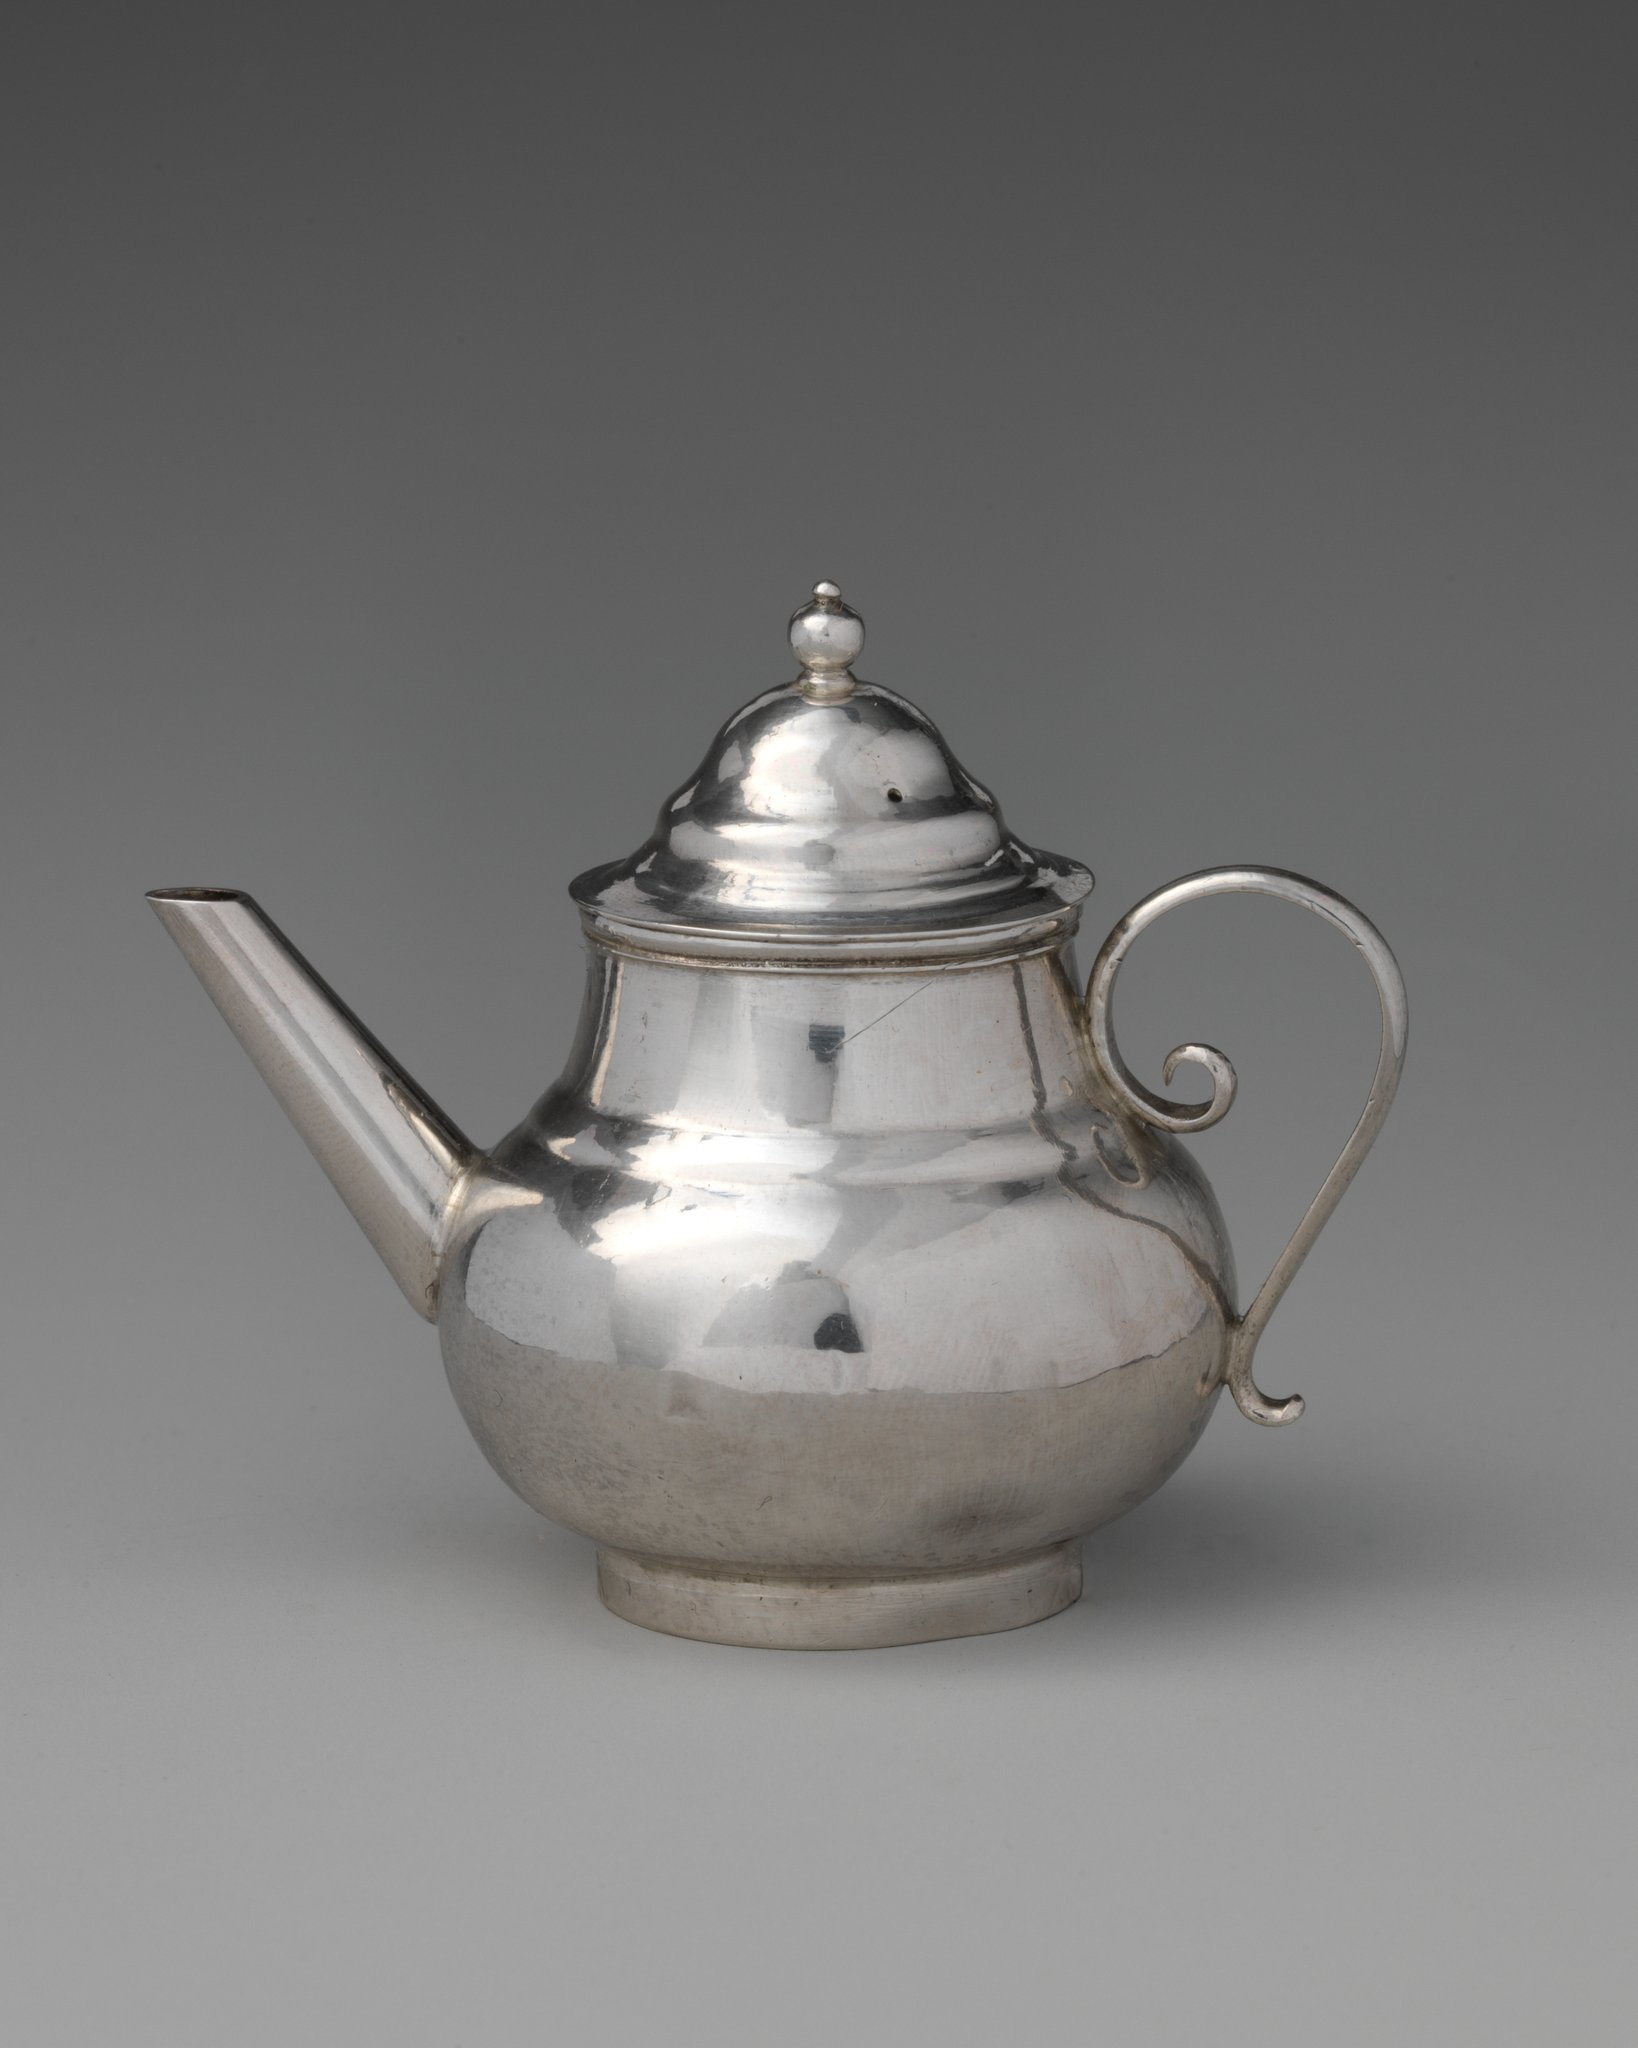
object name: teapot with cover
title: Miniature teapot with cover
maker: david clayton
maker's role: artist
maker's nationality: british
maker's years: 1659-1719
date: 1720-1730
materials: silver